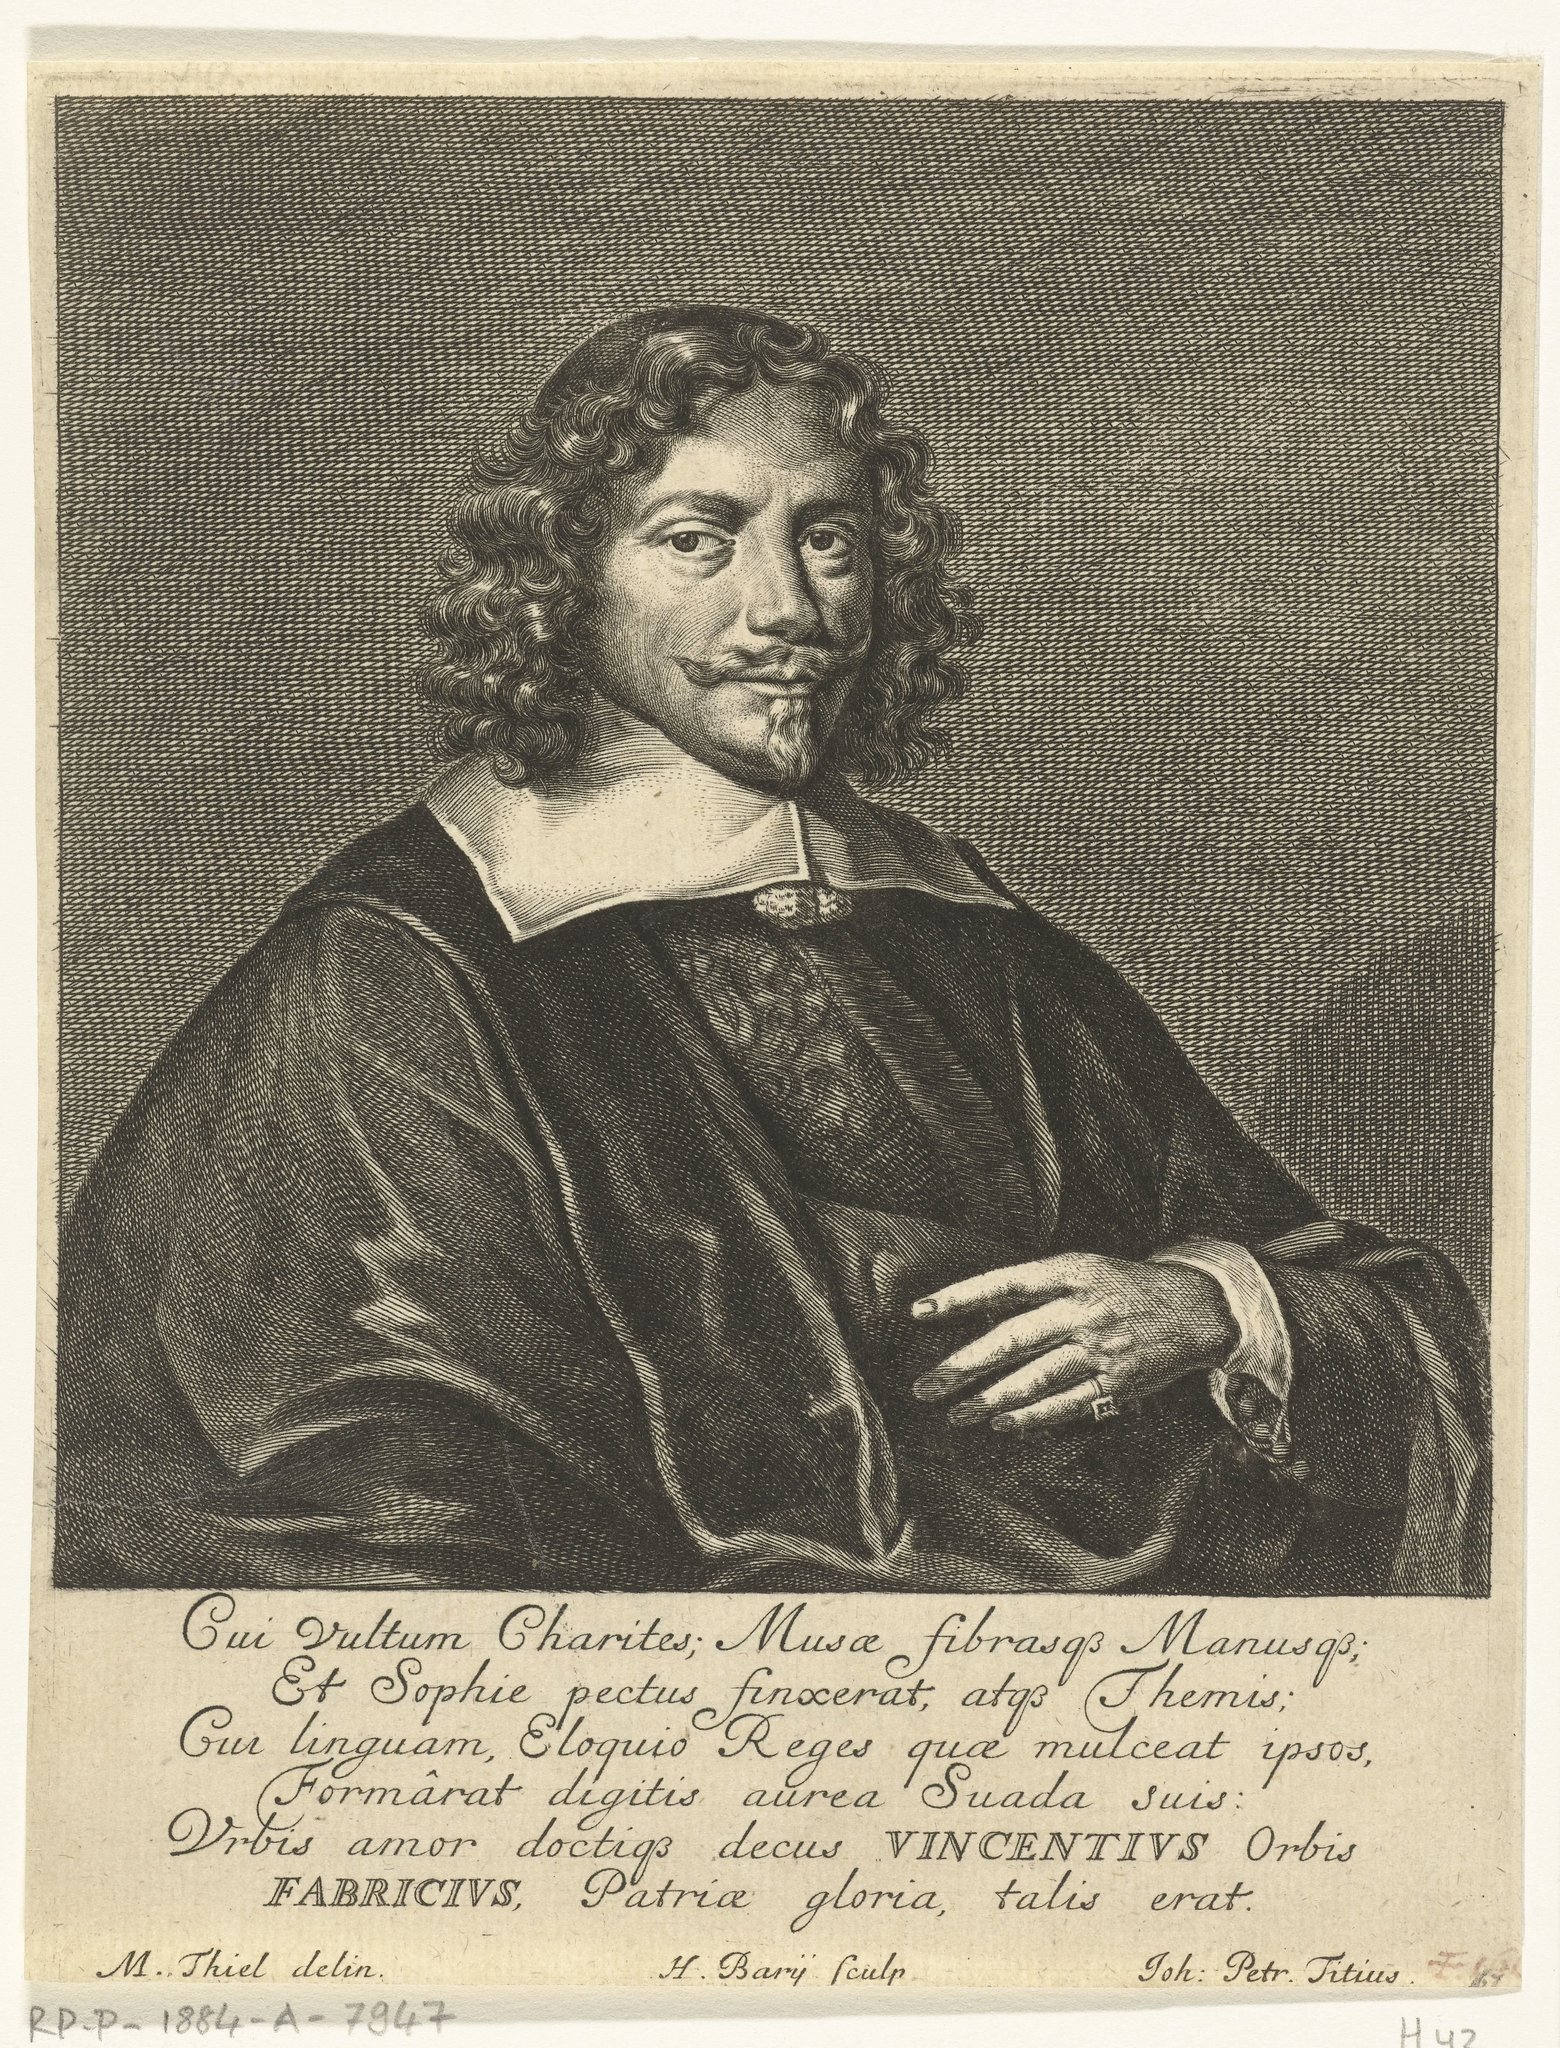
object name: print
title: Portret van Vincentius Fabricius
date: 1657-1707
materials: paper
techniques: engraving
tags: hamburg, schrijver, vincentius fabricius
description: Borstbeeld van Vincentius Fabricius, onder het portret een Latijns vers van zes regels.